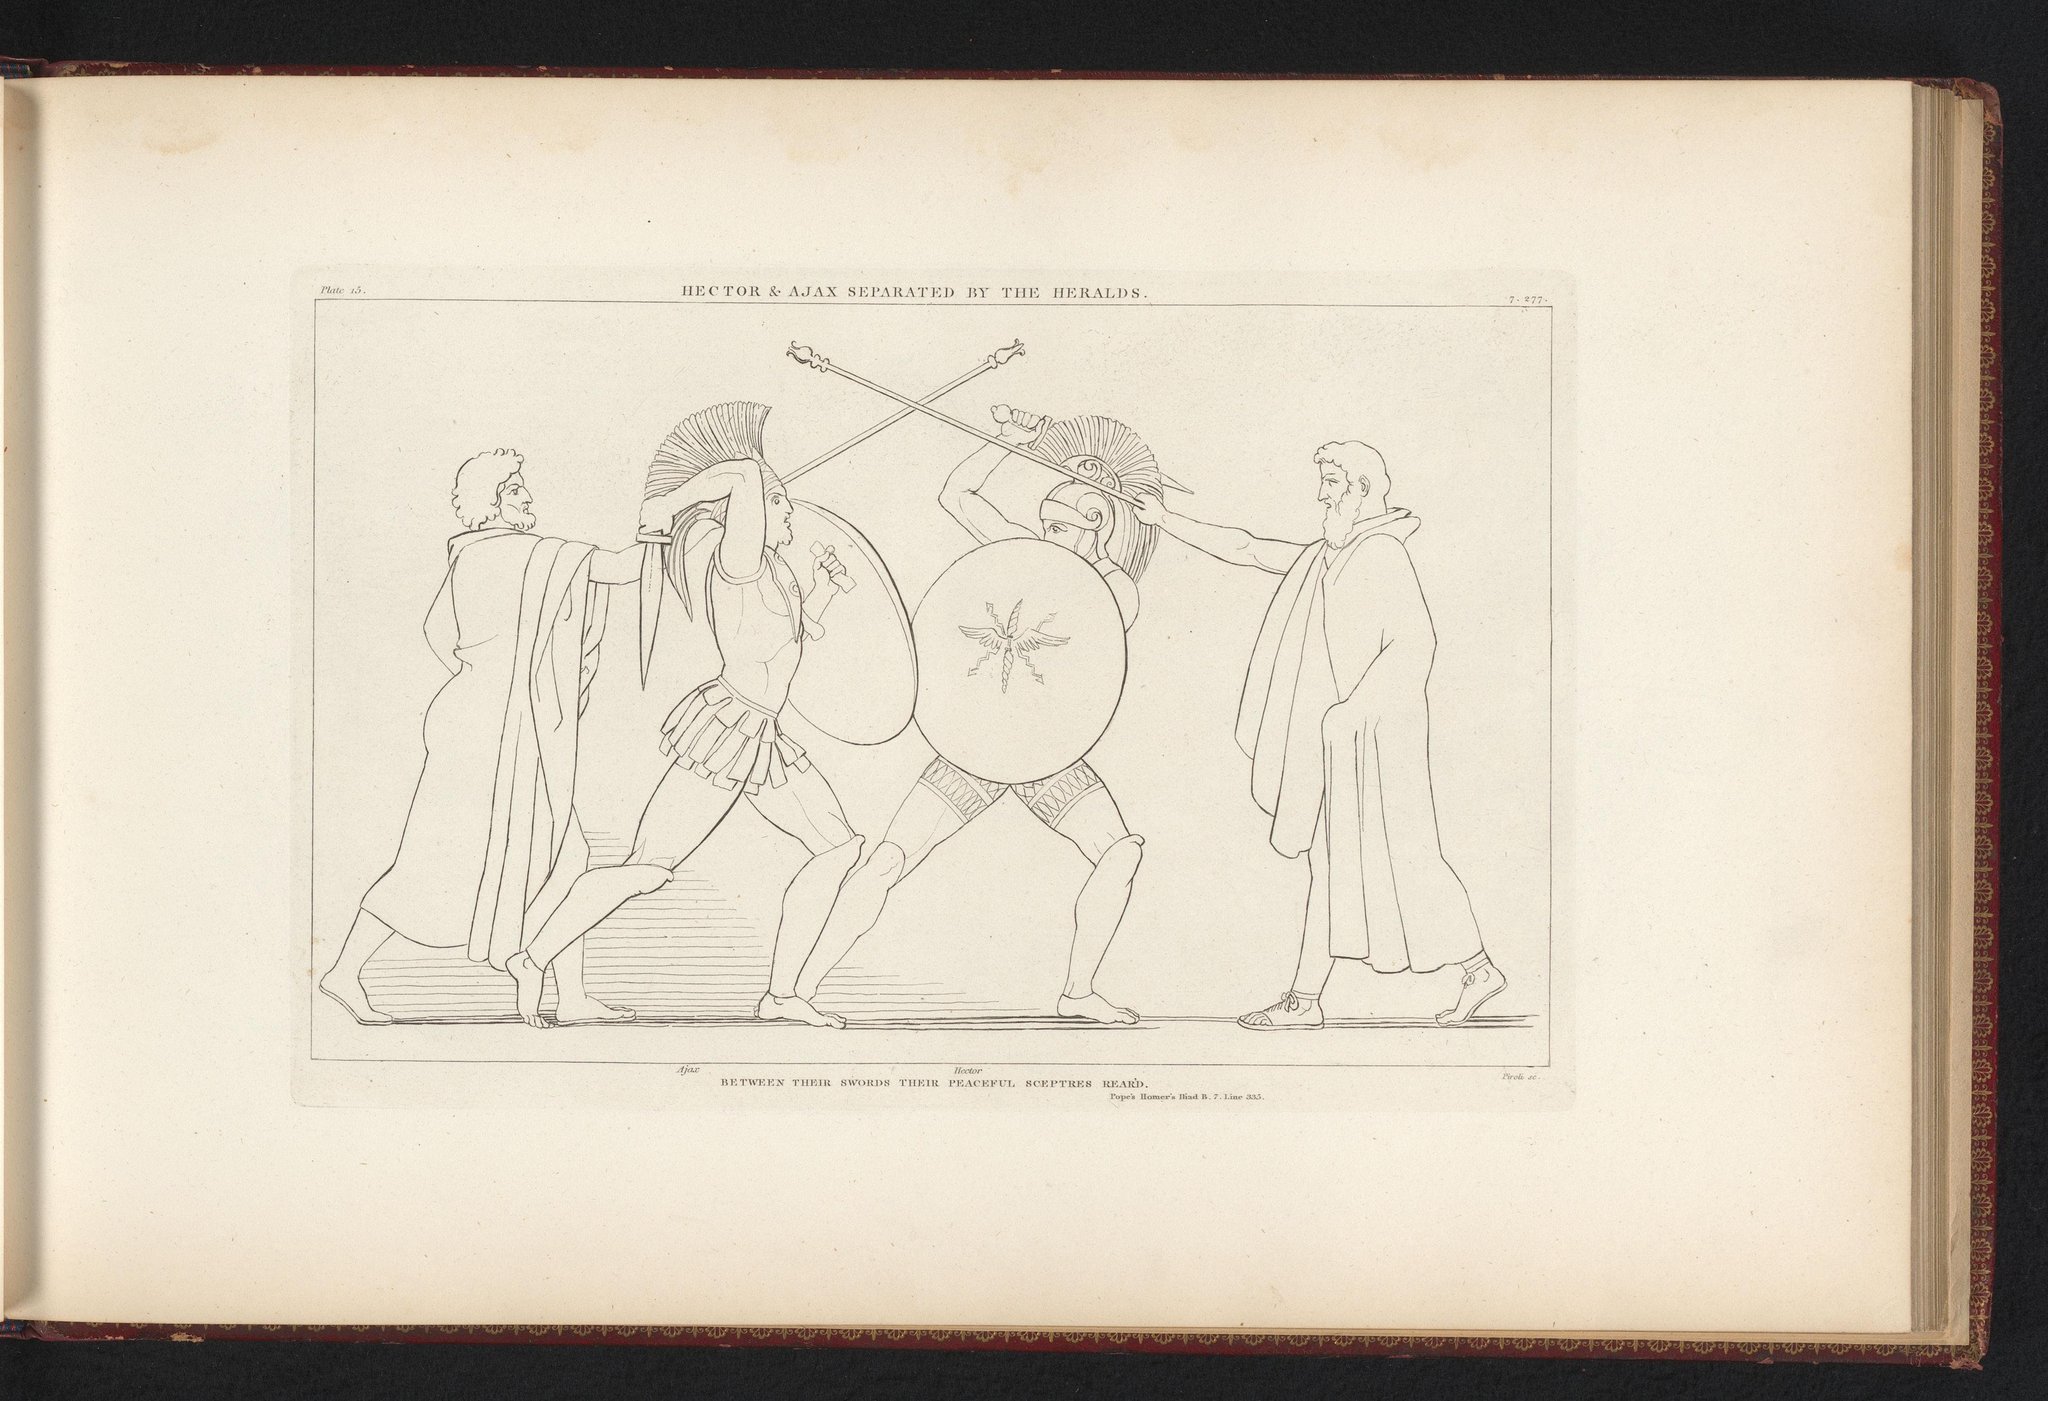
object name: print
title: Iliad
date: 1805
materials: paper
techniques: etching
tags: single combat between hector and ajax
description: Prent maakt onderdeel uit van een serie met 39 prenten over de Ilias, geschreven door Homerus.